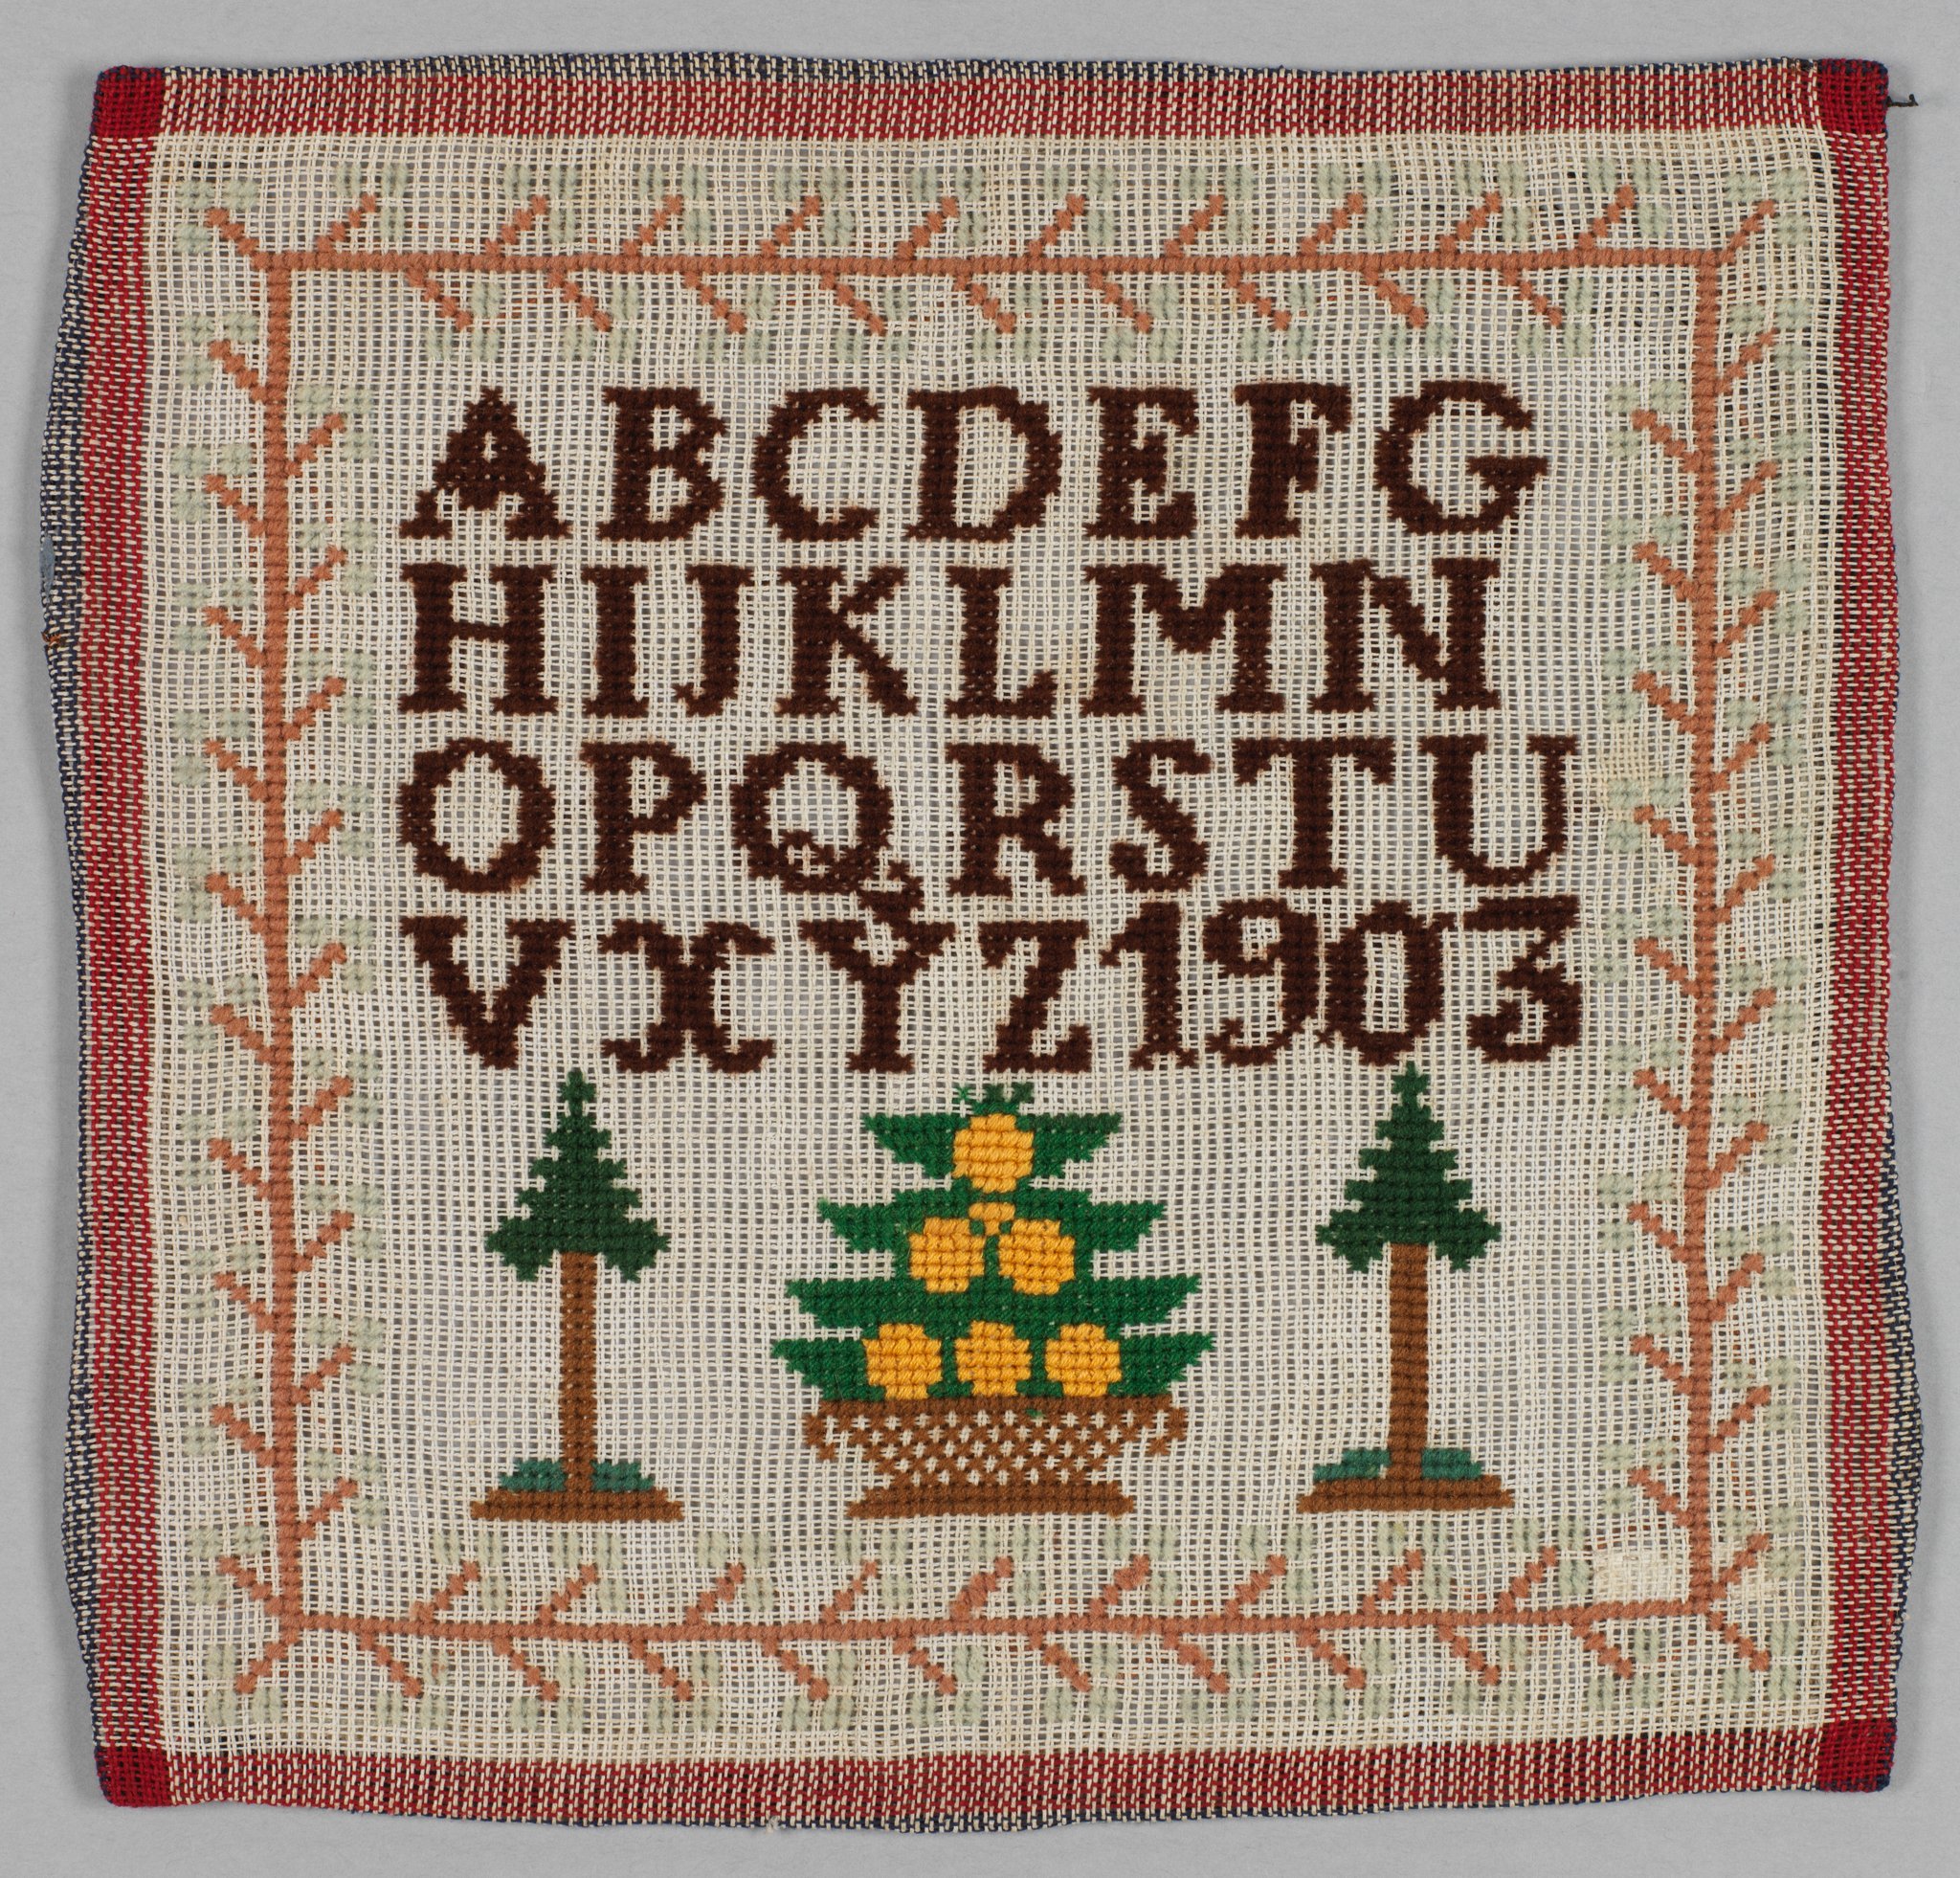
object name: sampler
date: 1903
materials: canvas, cotton, wool